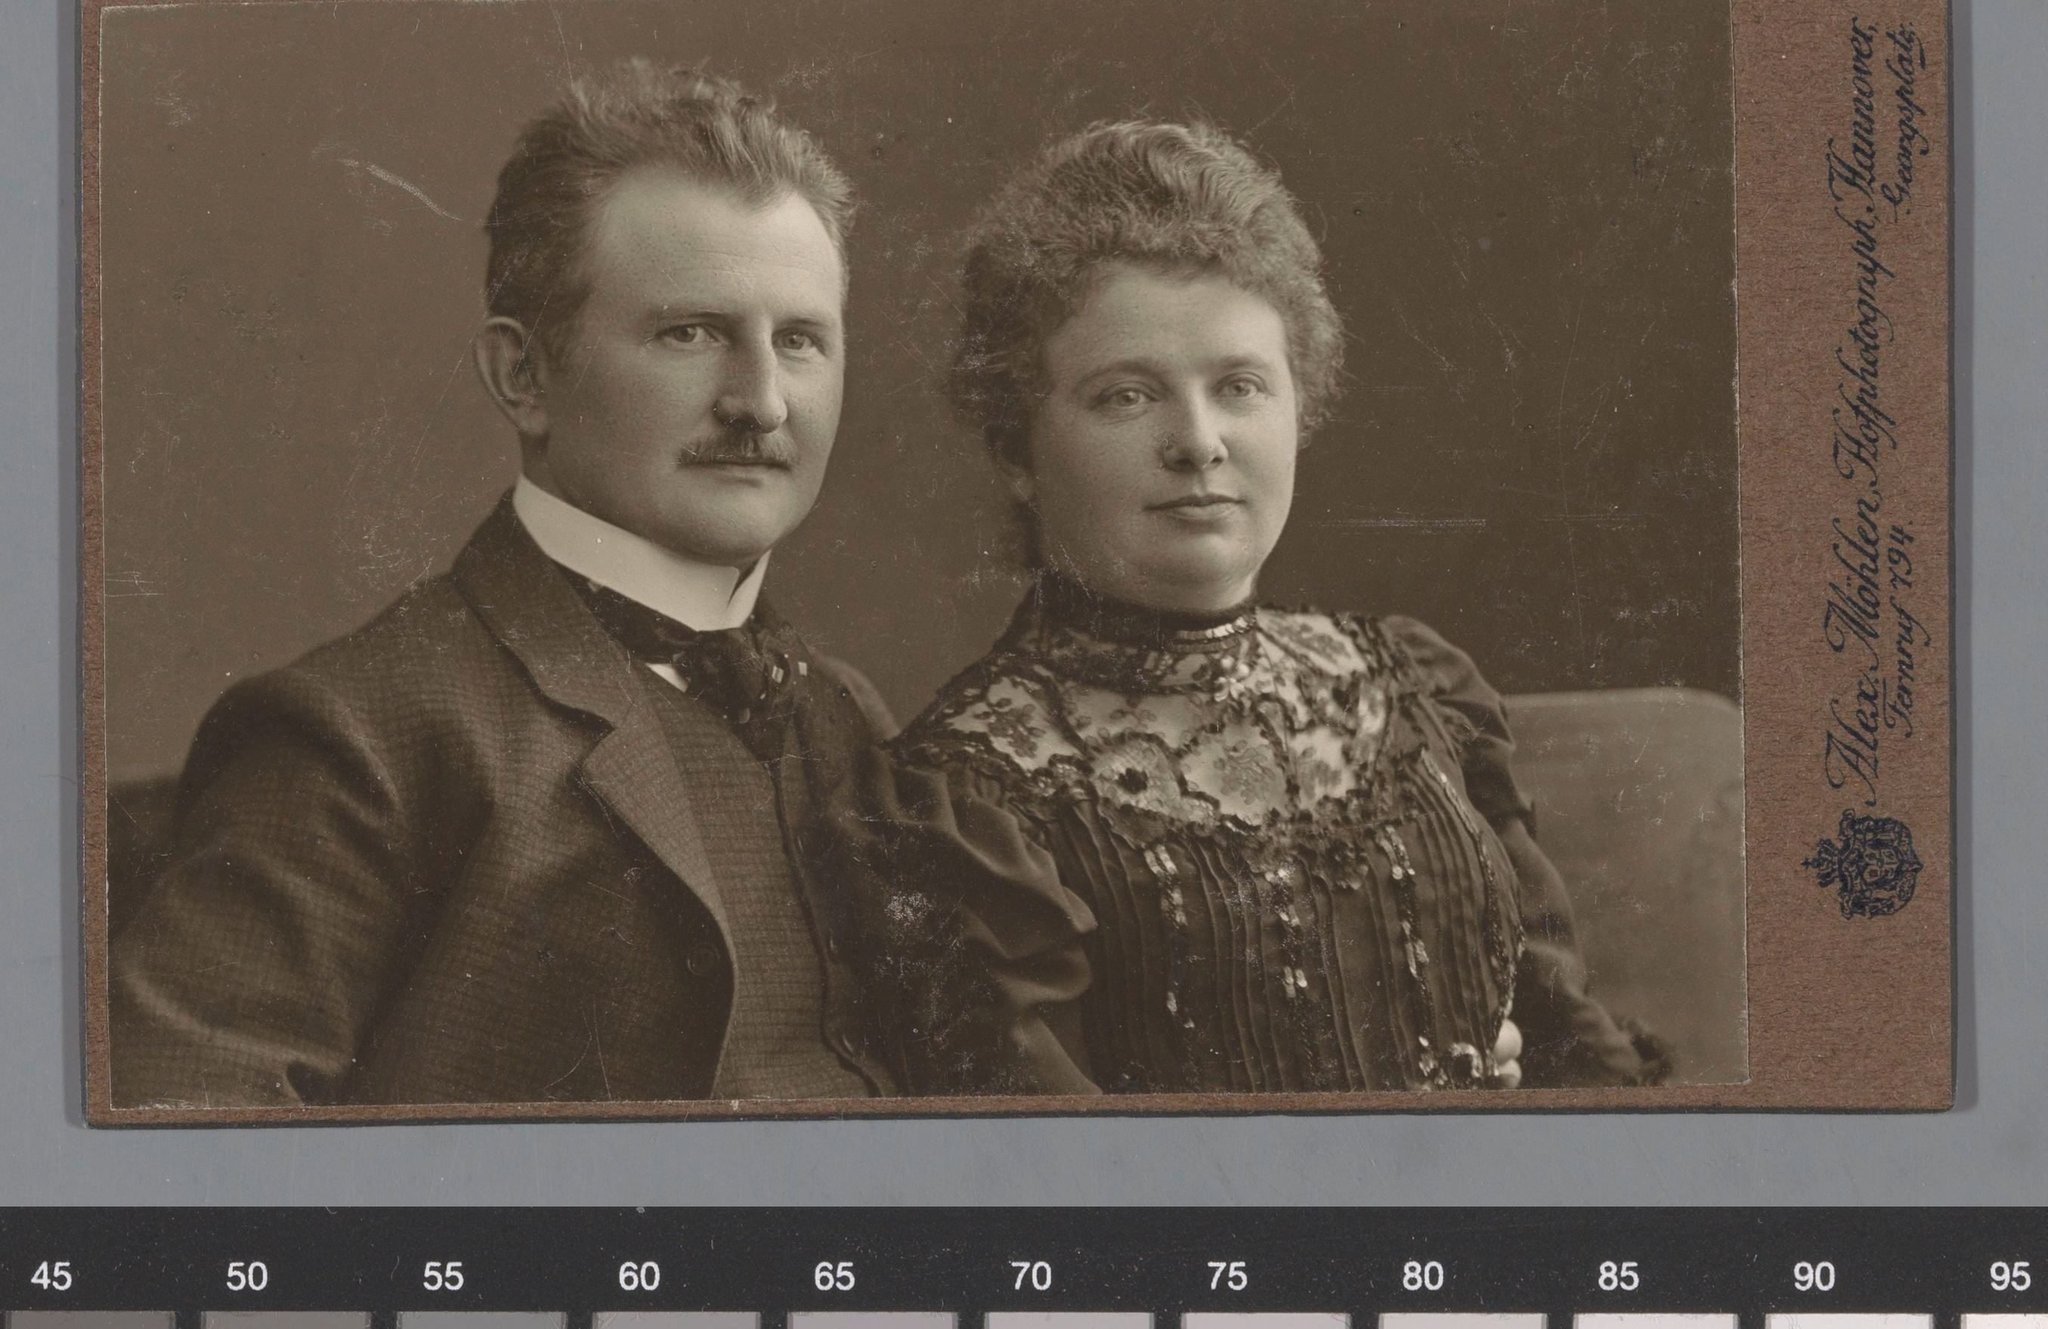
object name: carte de visite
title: Portret van echtpaar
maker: alexander möhlen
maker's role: fotograaf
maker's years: 1860-1930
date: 1860-1890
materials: cardboard, paper, photographic support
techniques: albumen print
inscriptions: address: ‘Alex Möhlen Hofphtograph Hannover/Fernruf794 Georgsplatz’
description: Links een man met een hoge witte boord en rechts een vrouw die enigszins tegen hem aan leunt.